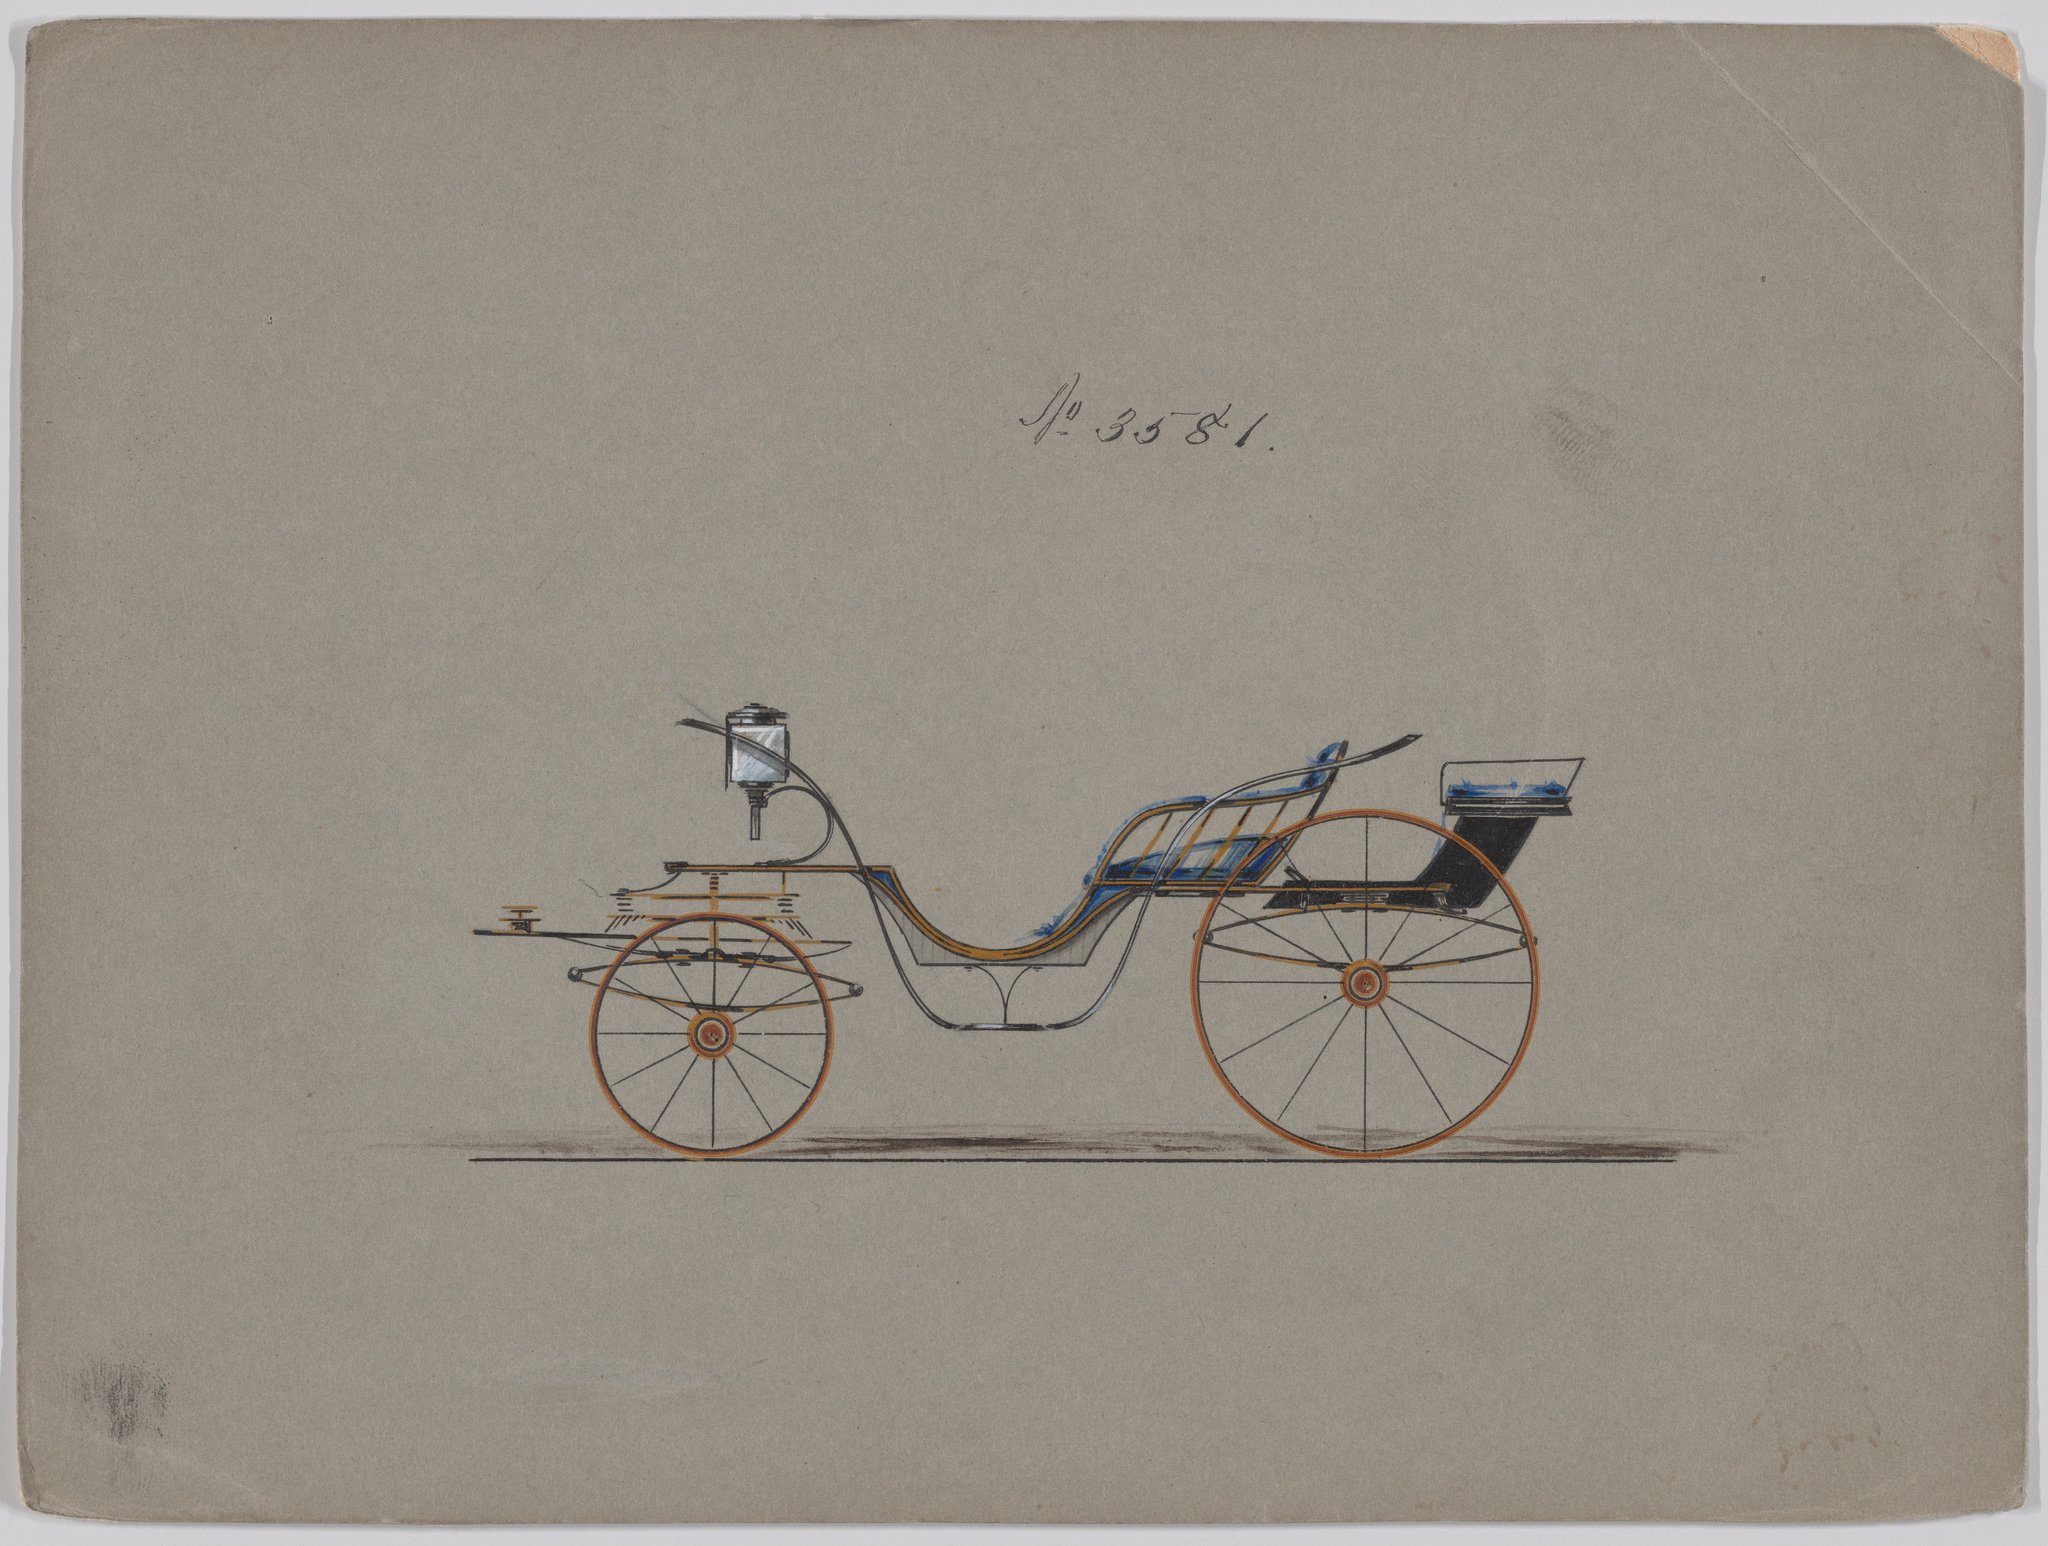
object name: drawing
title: Design for Pony Phaeton, no. 3581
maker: brewster & co.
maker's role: manufacturer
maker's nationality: american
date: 1880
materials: gouache, gum arabic, ink, watercolor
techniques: pen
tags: carriages